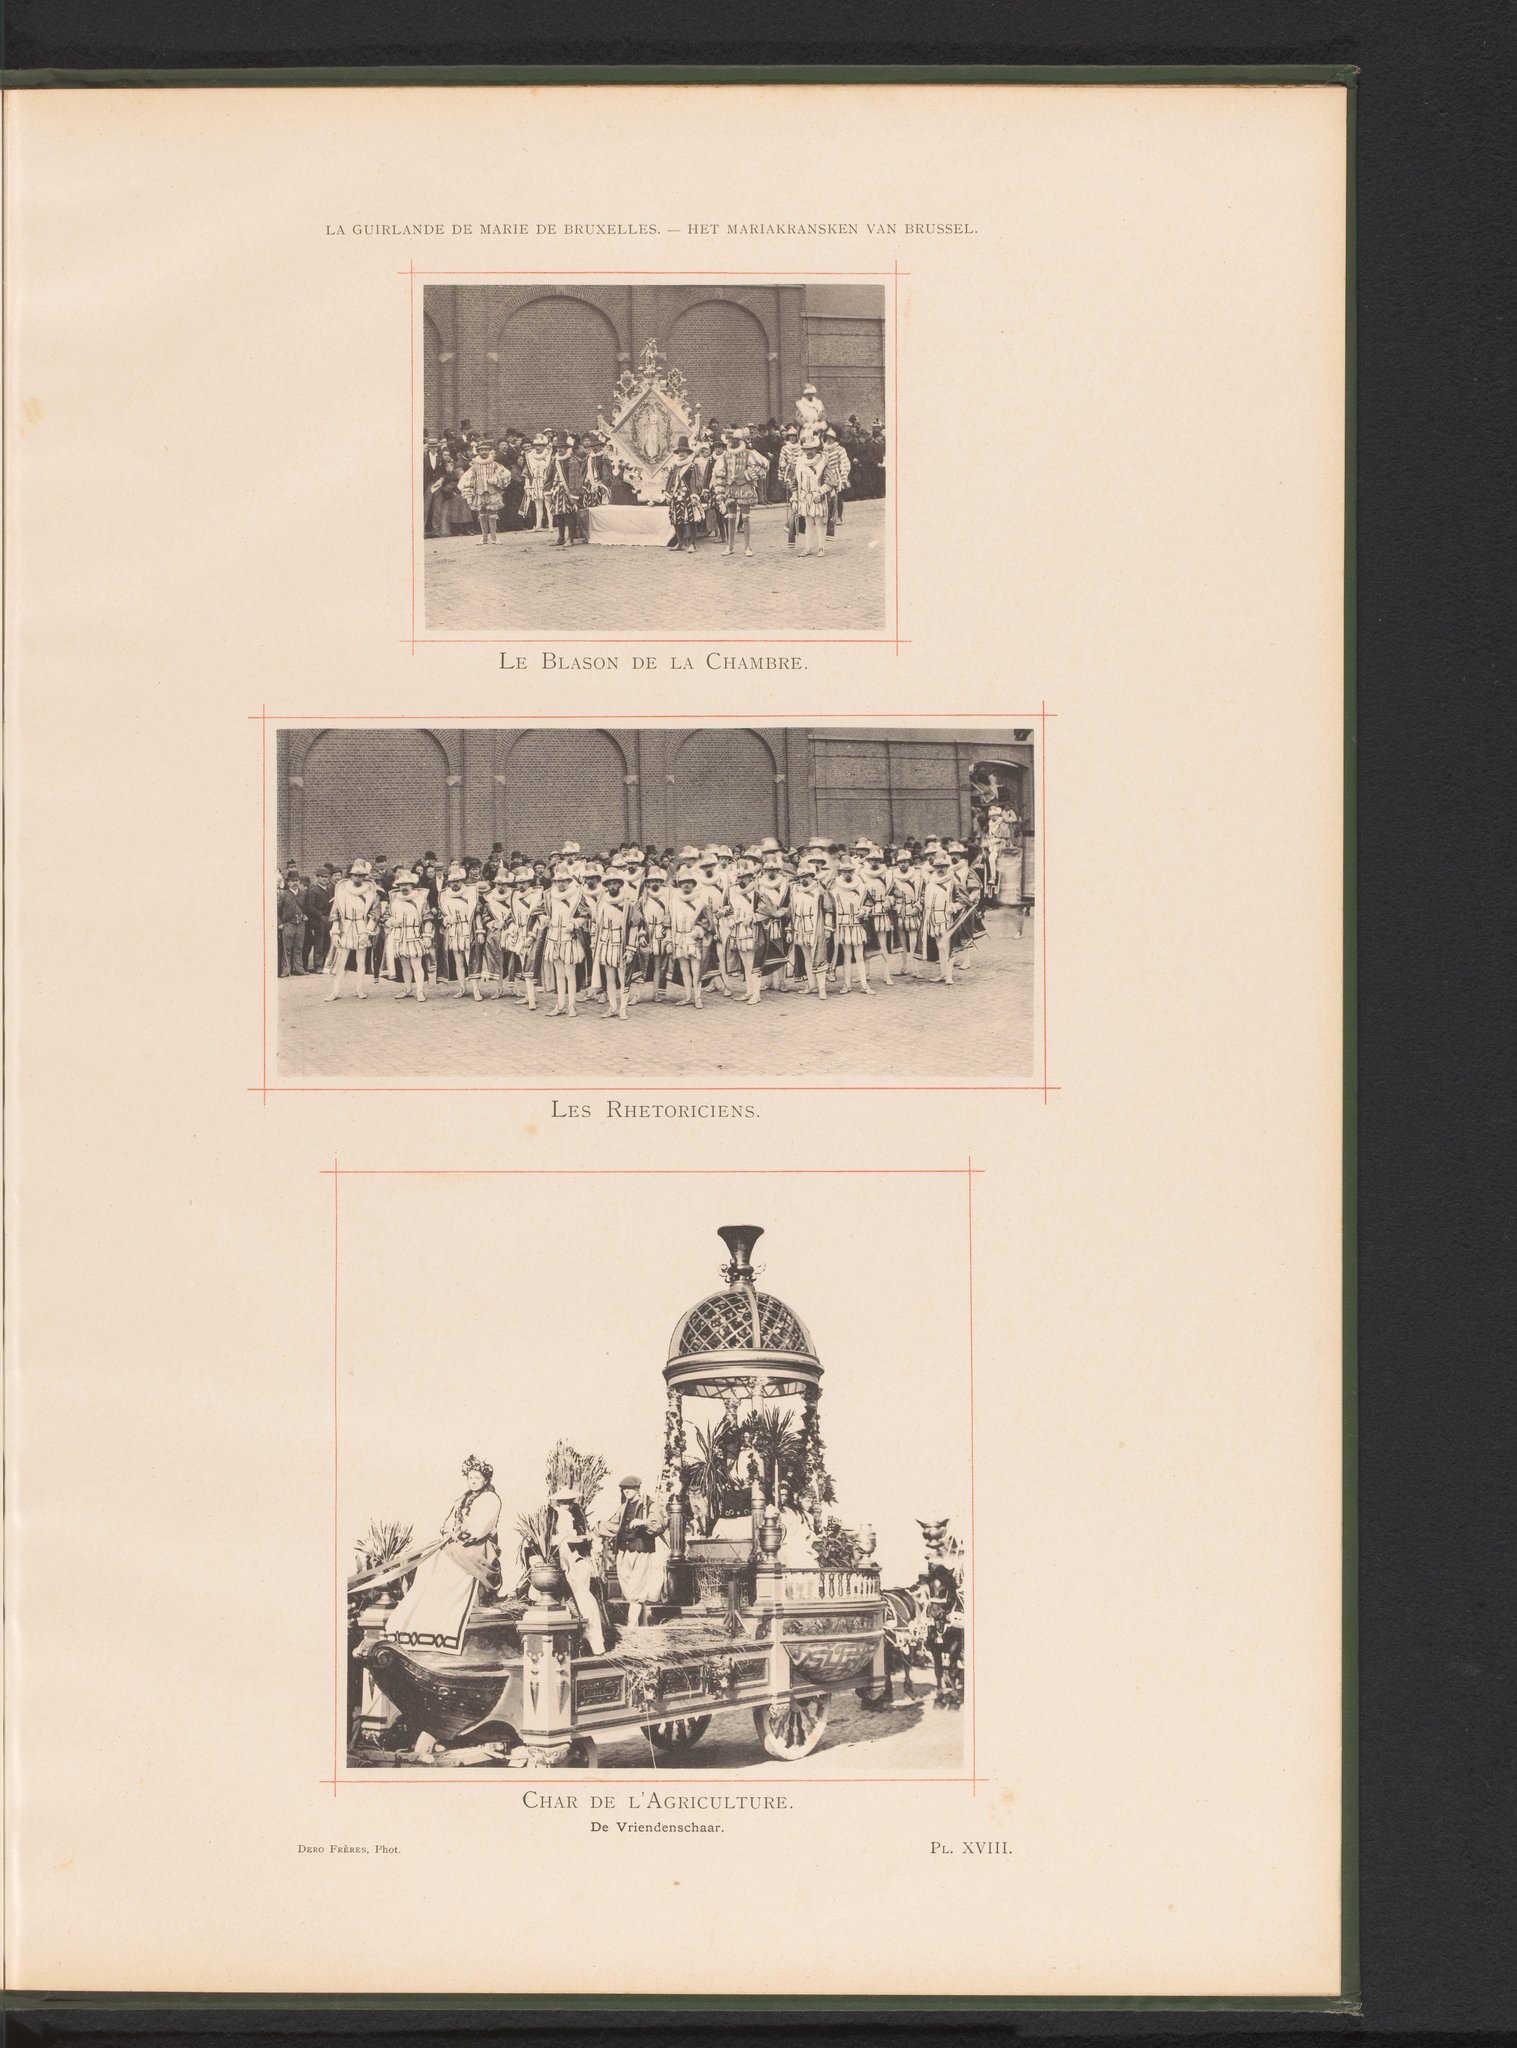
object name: page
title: Le Blason de la Chambre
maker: joseph maes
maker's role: fotograaf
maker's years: 1838-1908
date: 1892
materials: paper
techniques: photograph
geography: antwerp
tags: public festivities (+ parade, pageant, cavalcade ~ festive activities), antwerp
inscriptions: number: ‘Pl. XVIII.’, inscription: ‘LA GUIRLANDE DE MARIE DE BRUXELLES. - HET MARIAKRANSKEN VAN BRUSSEL.’, inscription: ‘De Vriendenschaar.’